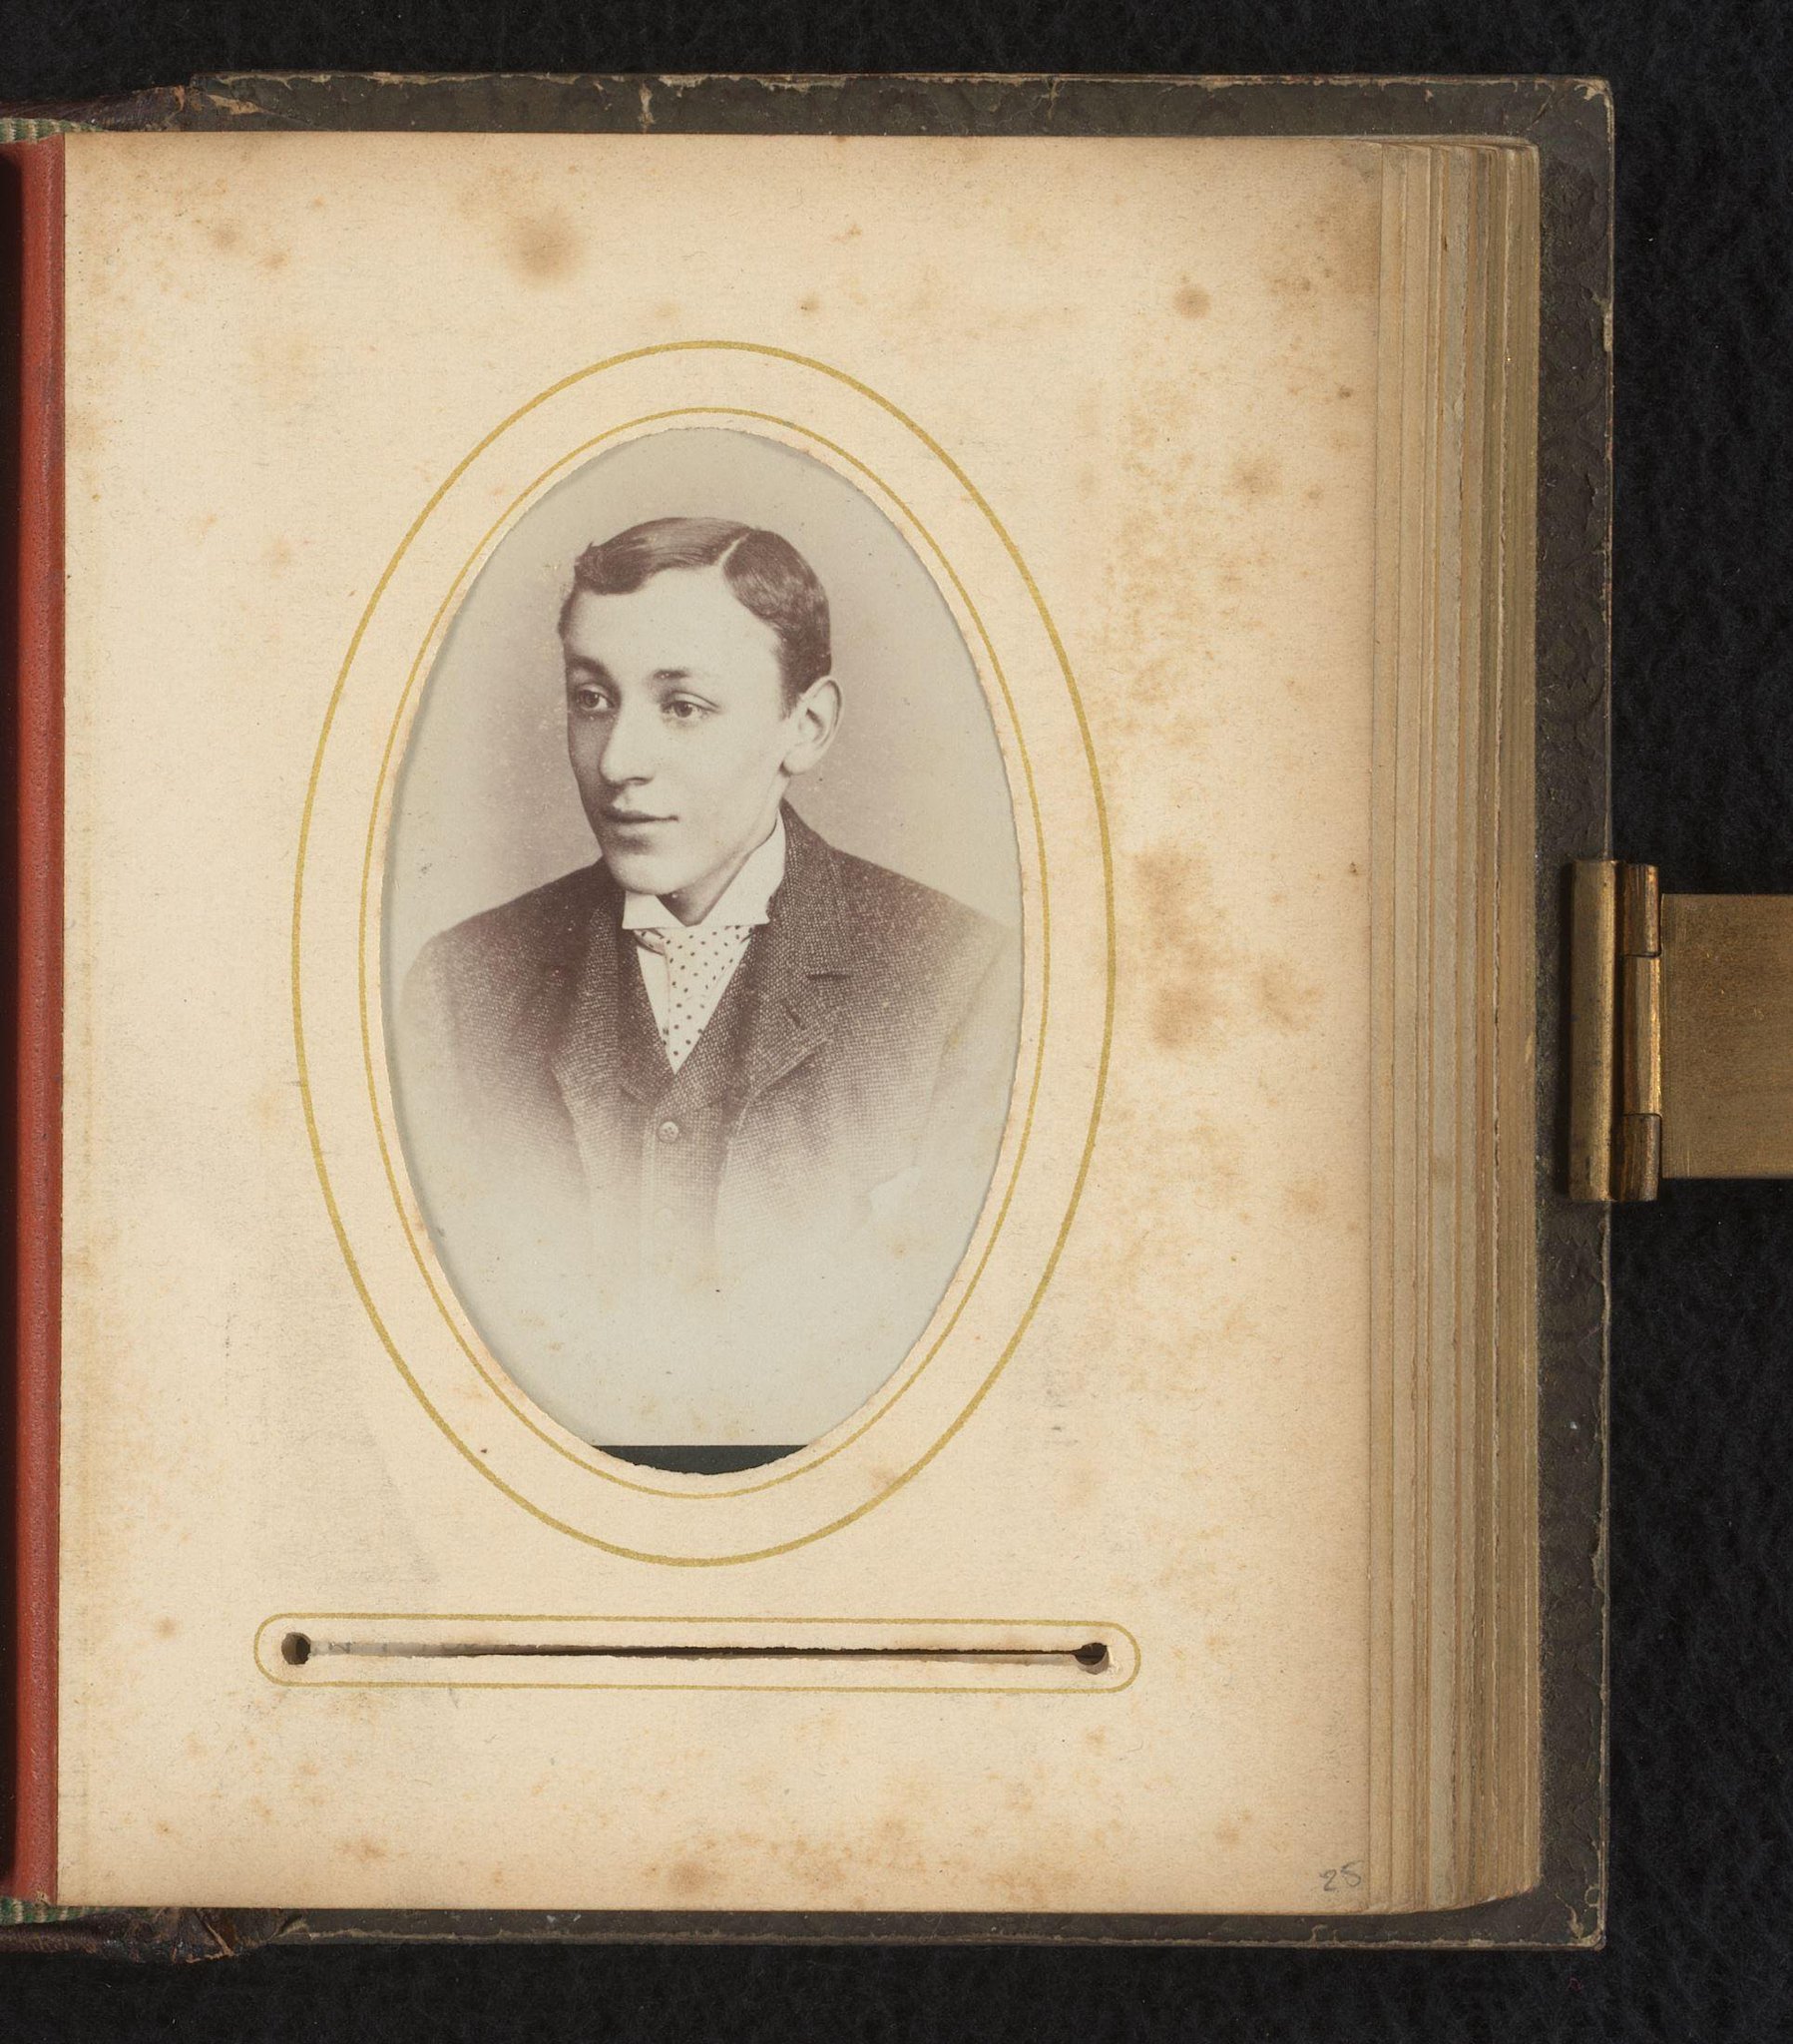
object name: album leaf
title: Portret van een jongeman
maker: harold tracey trew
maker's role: fotograaf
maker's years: 1852-1934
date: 1891-1892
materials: cardboard, photographic support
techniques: albumen print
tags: historical persons, youth, adolescent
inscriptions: inscription: ‘Trew The Finsbury Park Studio/ (Corner of Isledon Road)’